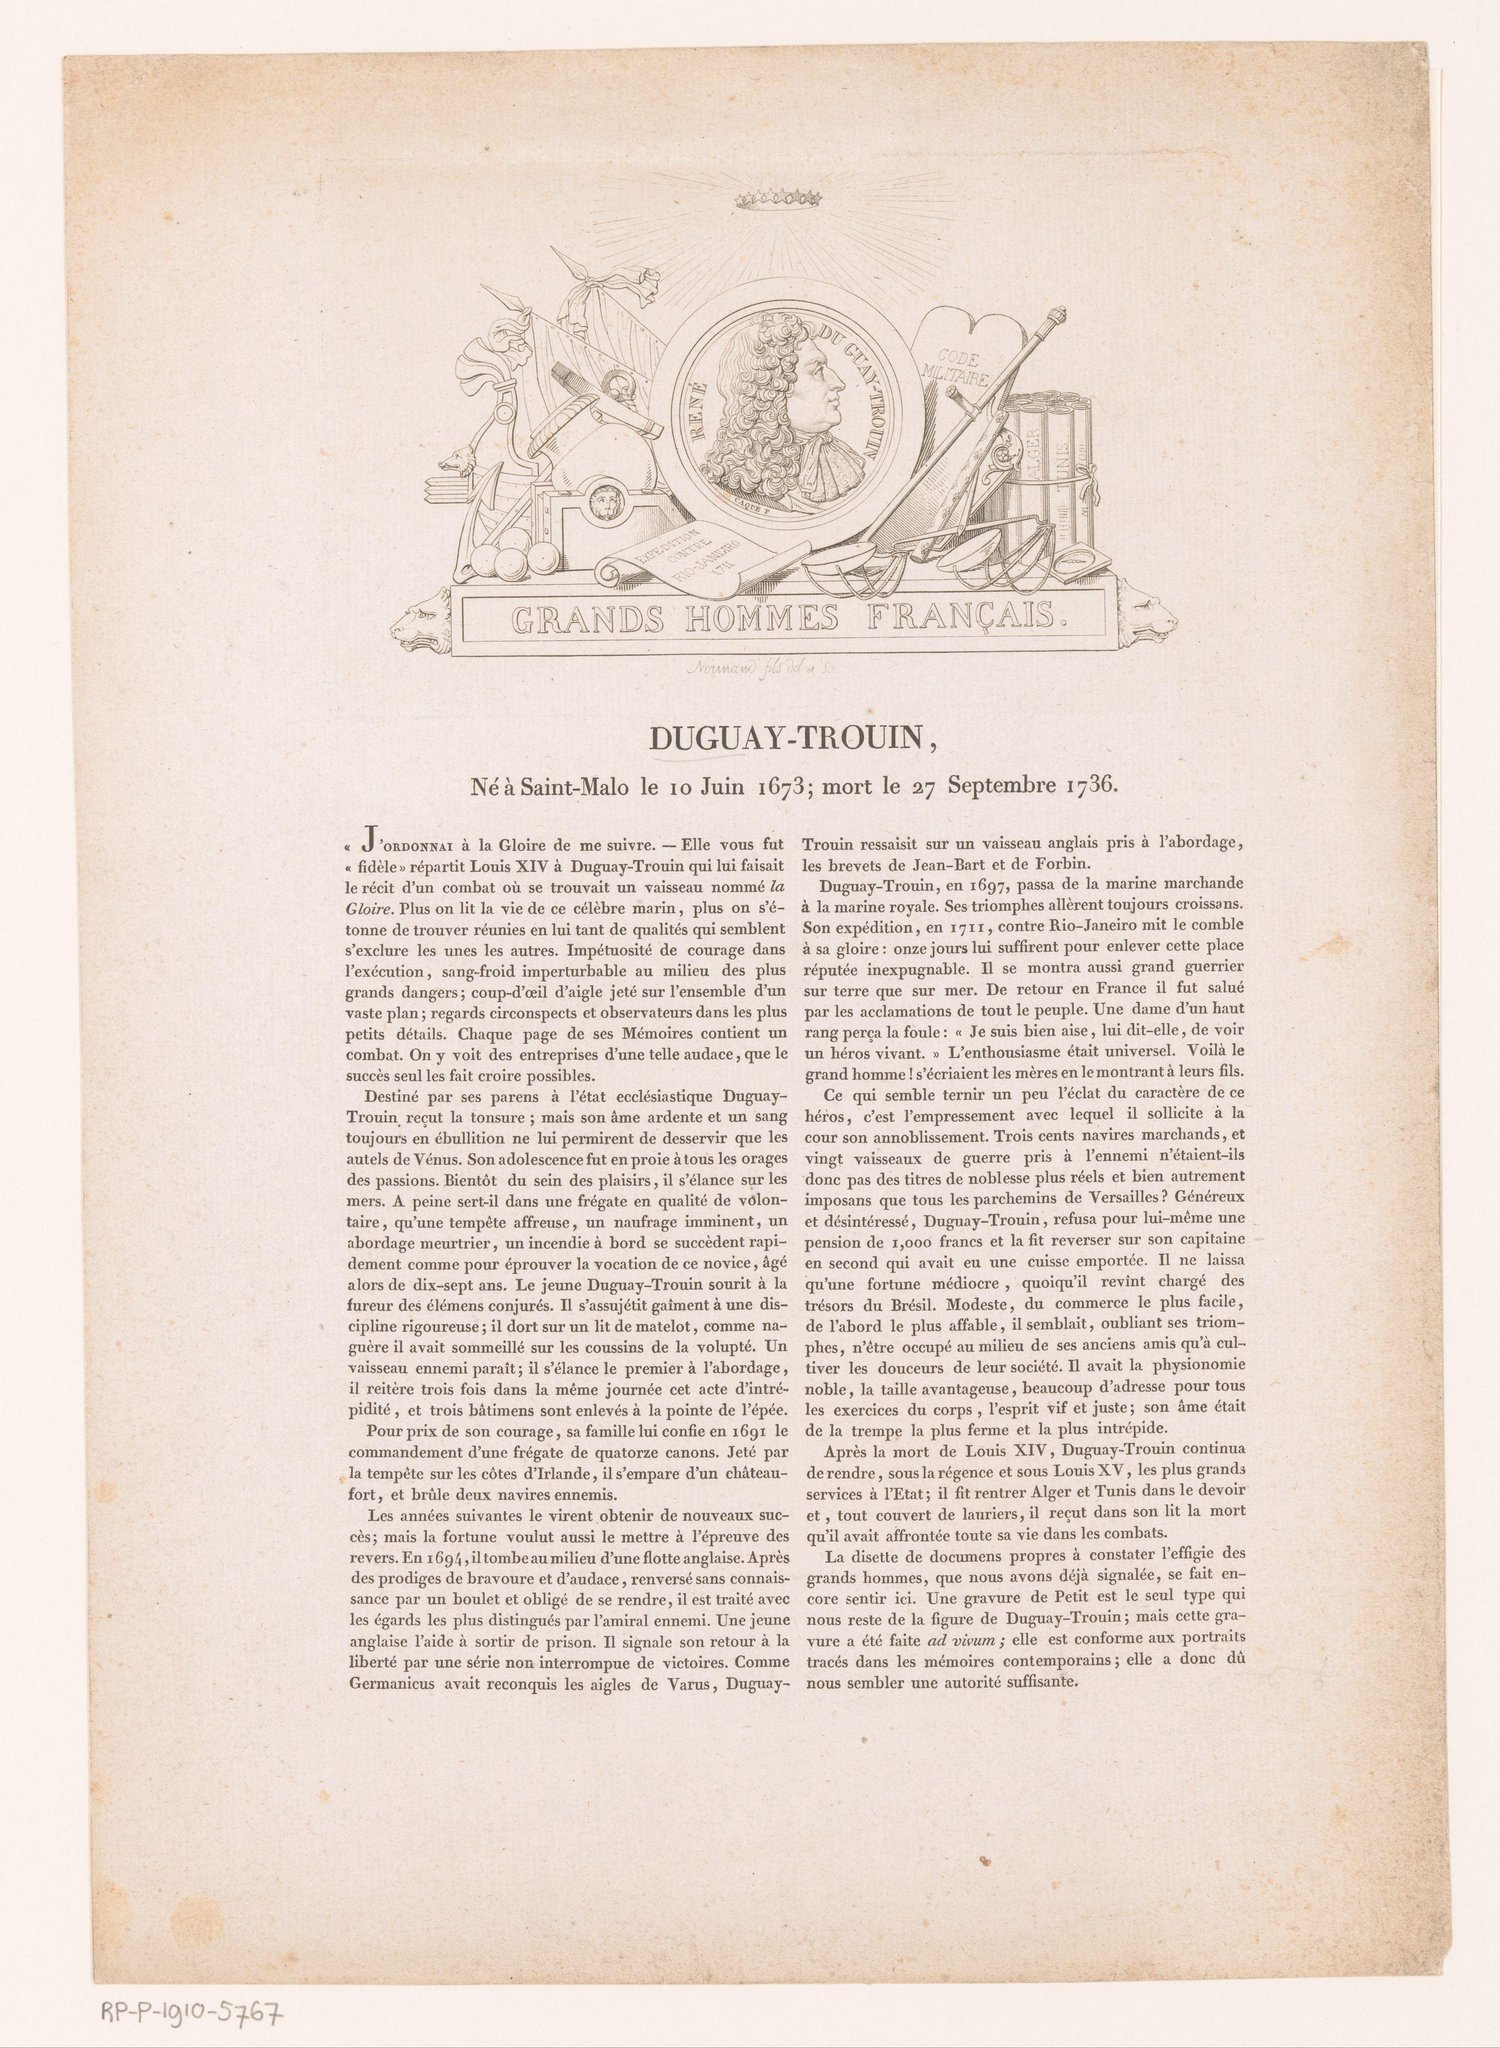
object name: print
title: Duguay-Trouin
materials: paper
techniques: etching, letterpress printing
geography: paris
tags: paris, pirate, corsair, buccaneer, historical persons, ranks in the navy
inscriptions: collector's mark: Lugt 2228